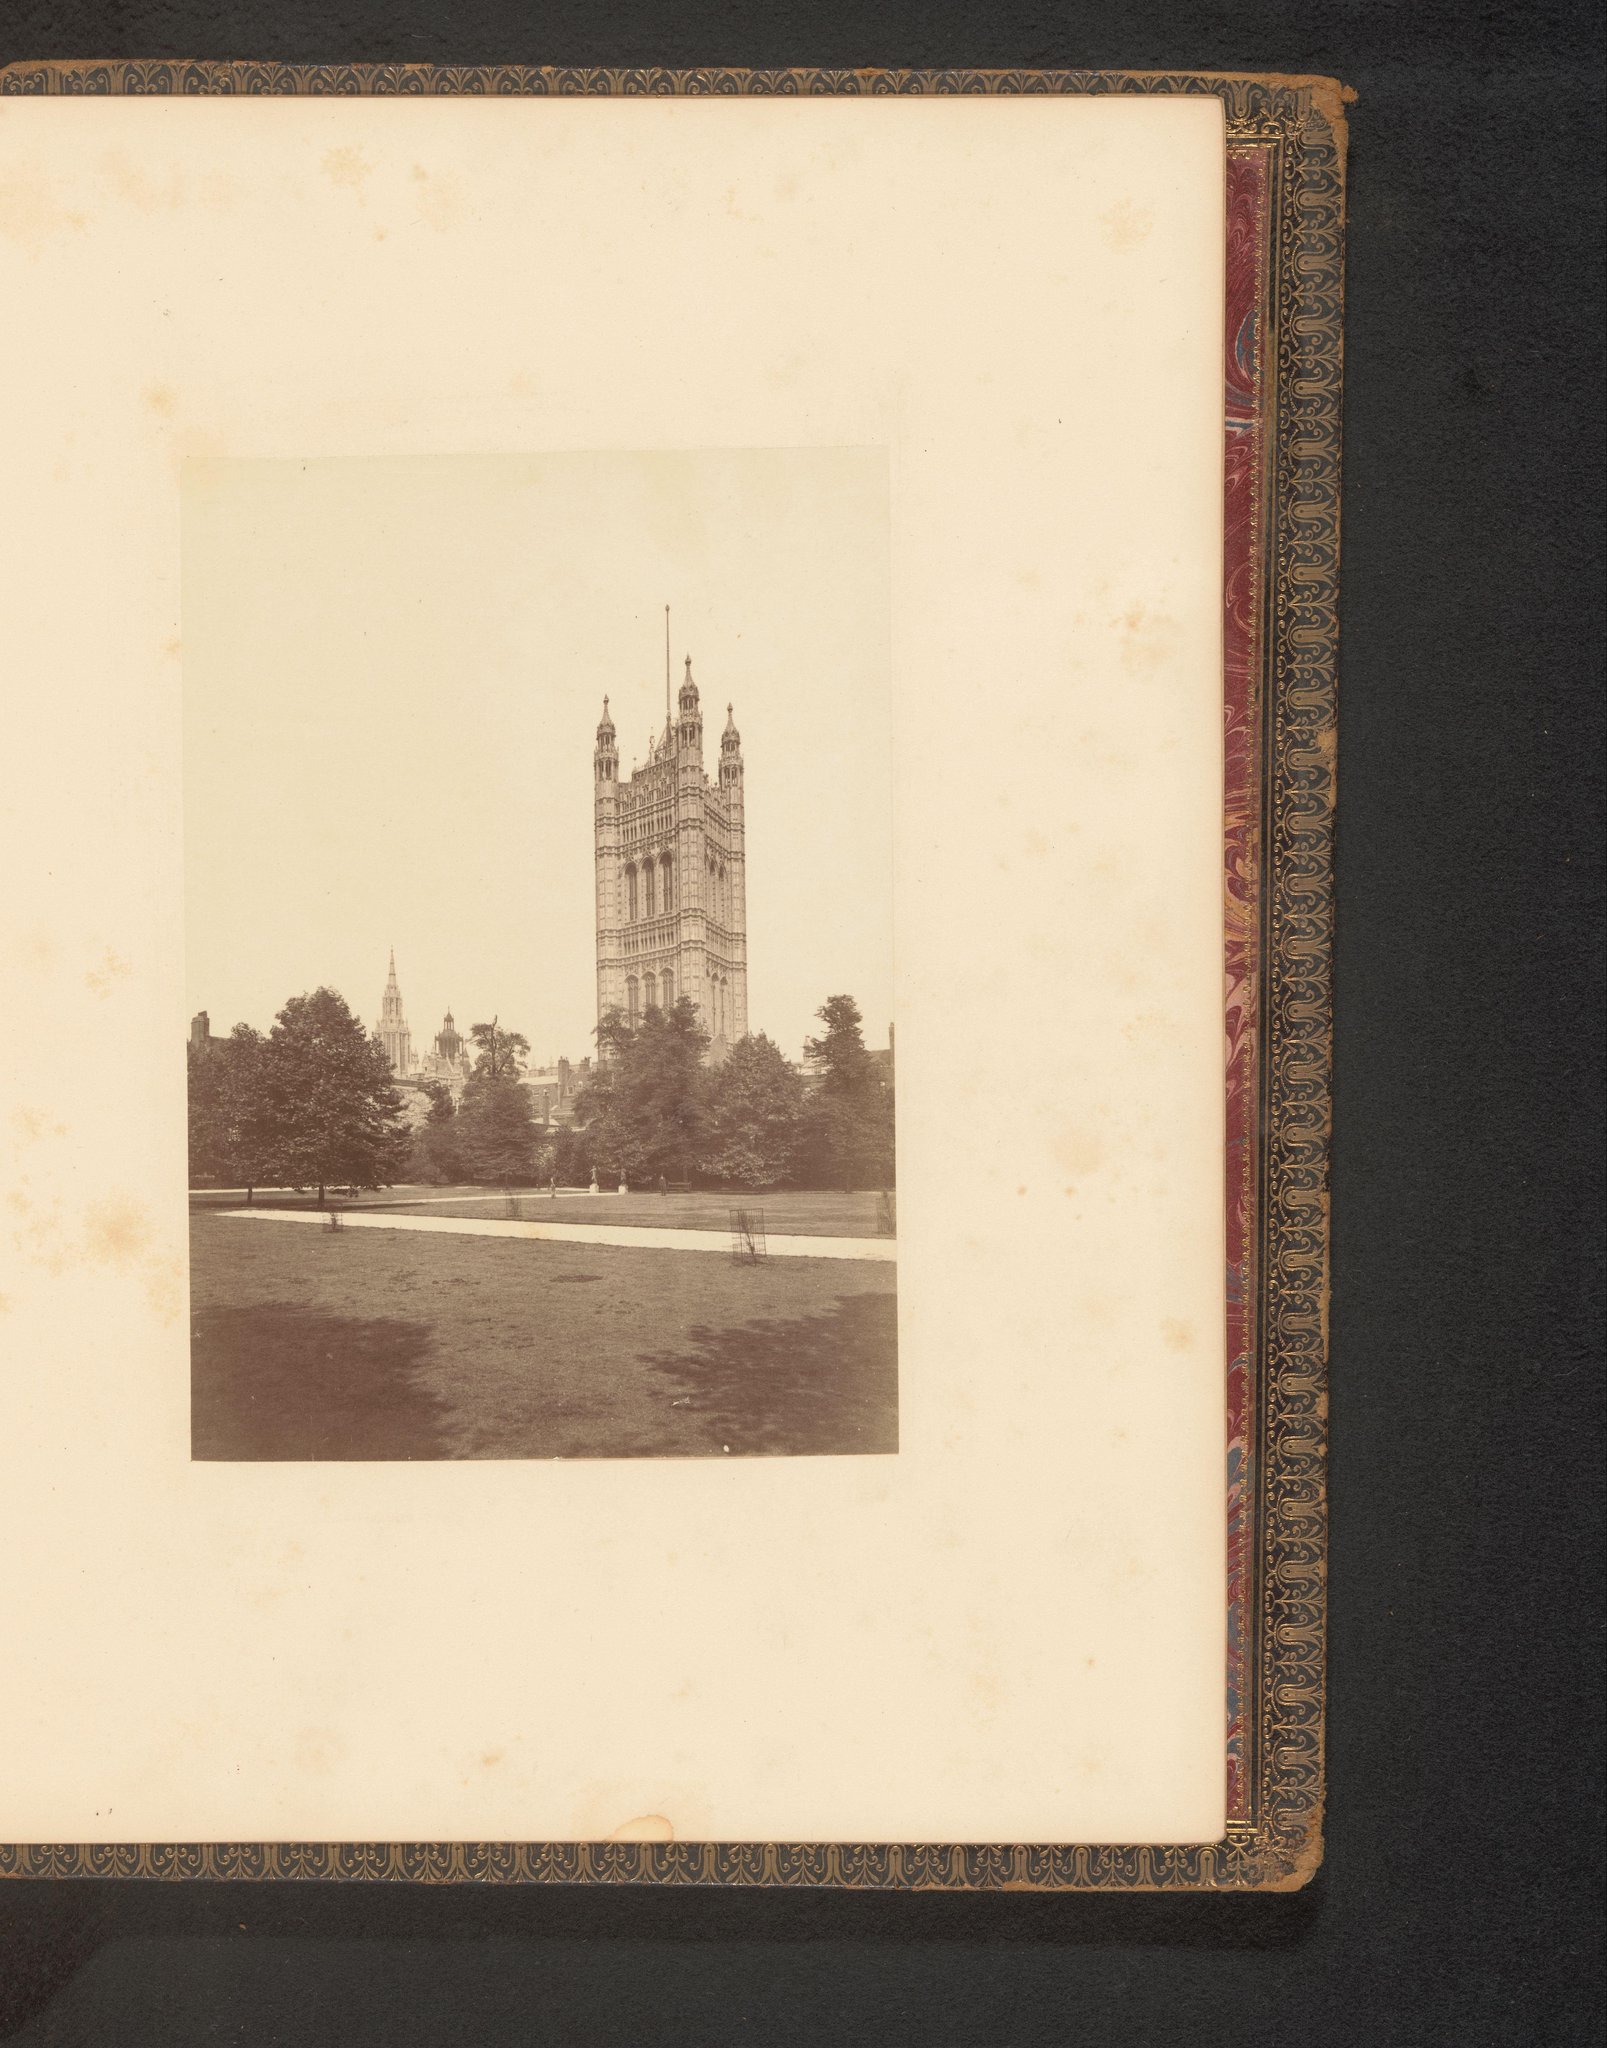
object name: photograph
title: Gezicht op Victoria Tower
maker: john harrington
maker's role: fotograaf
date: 1864-1869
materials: photographic support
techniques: albumen print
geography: london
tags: tower (of house or building)